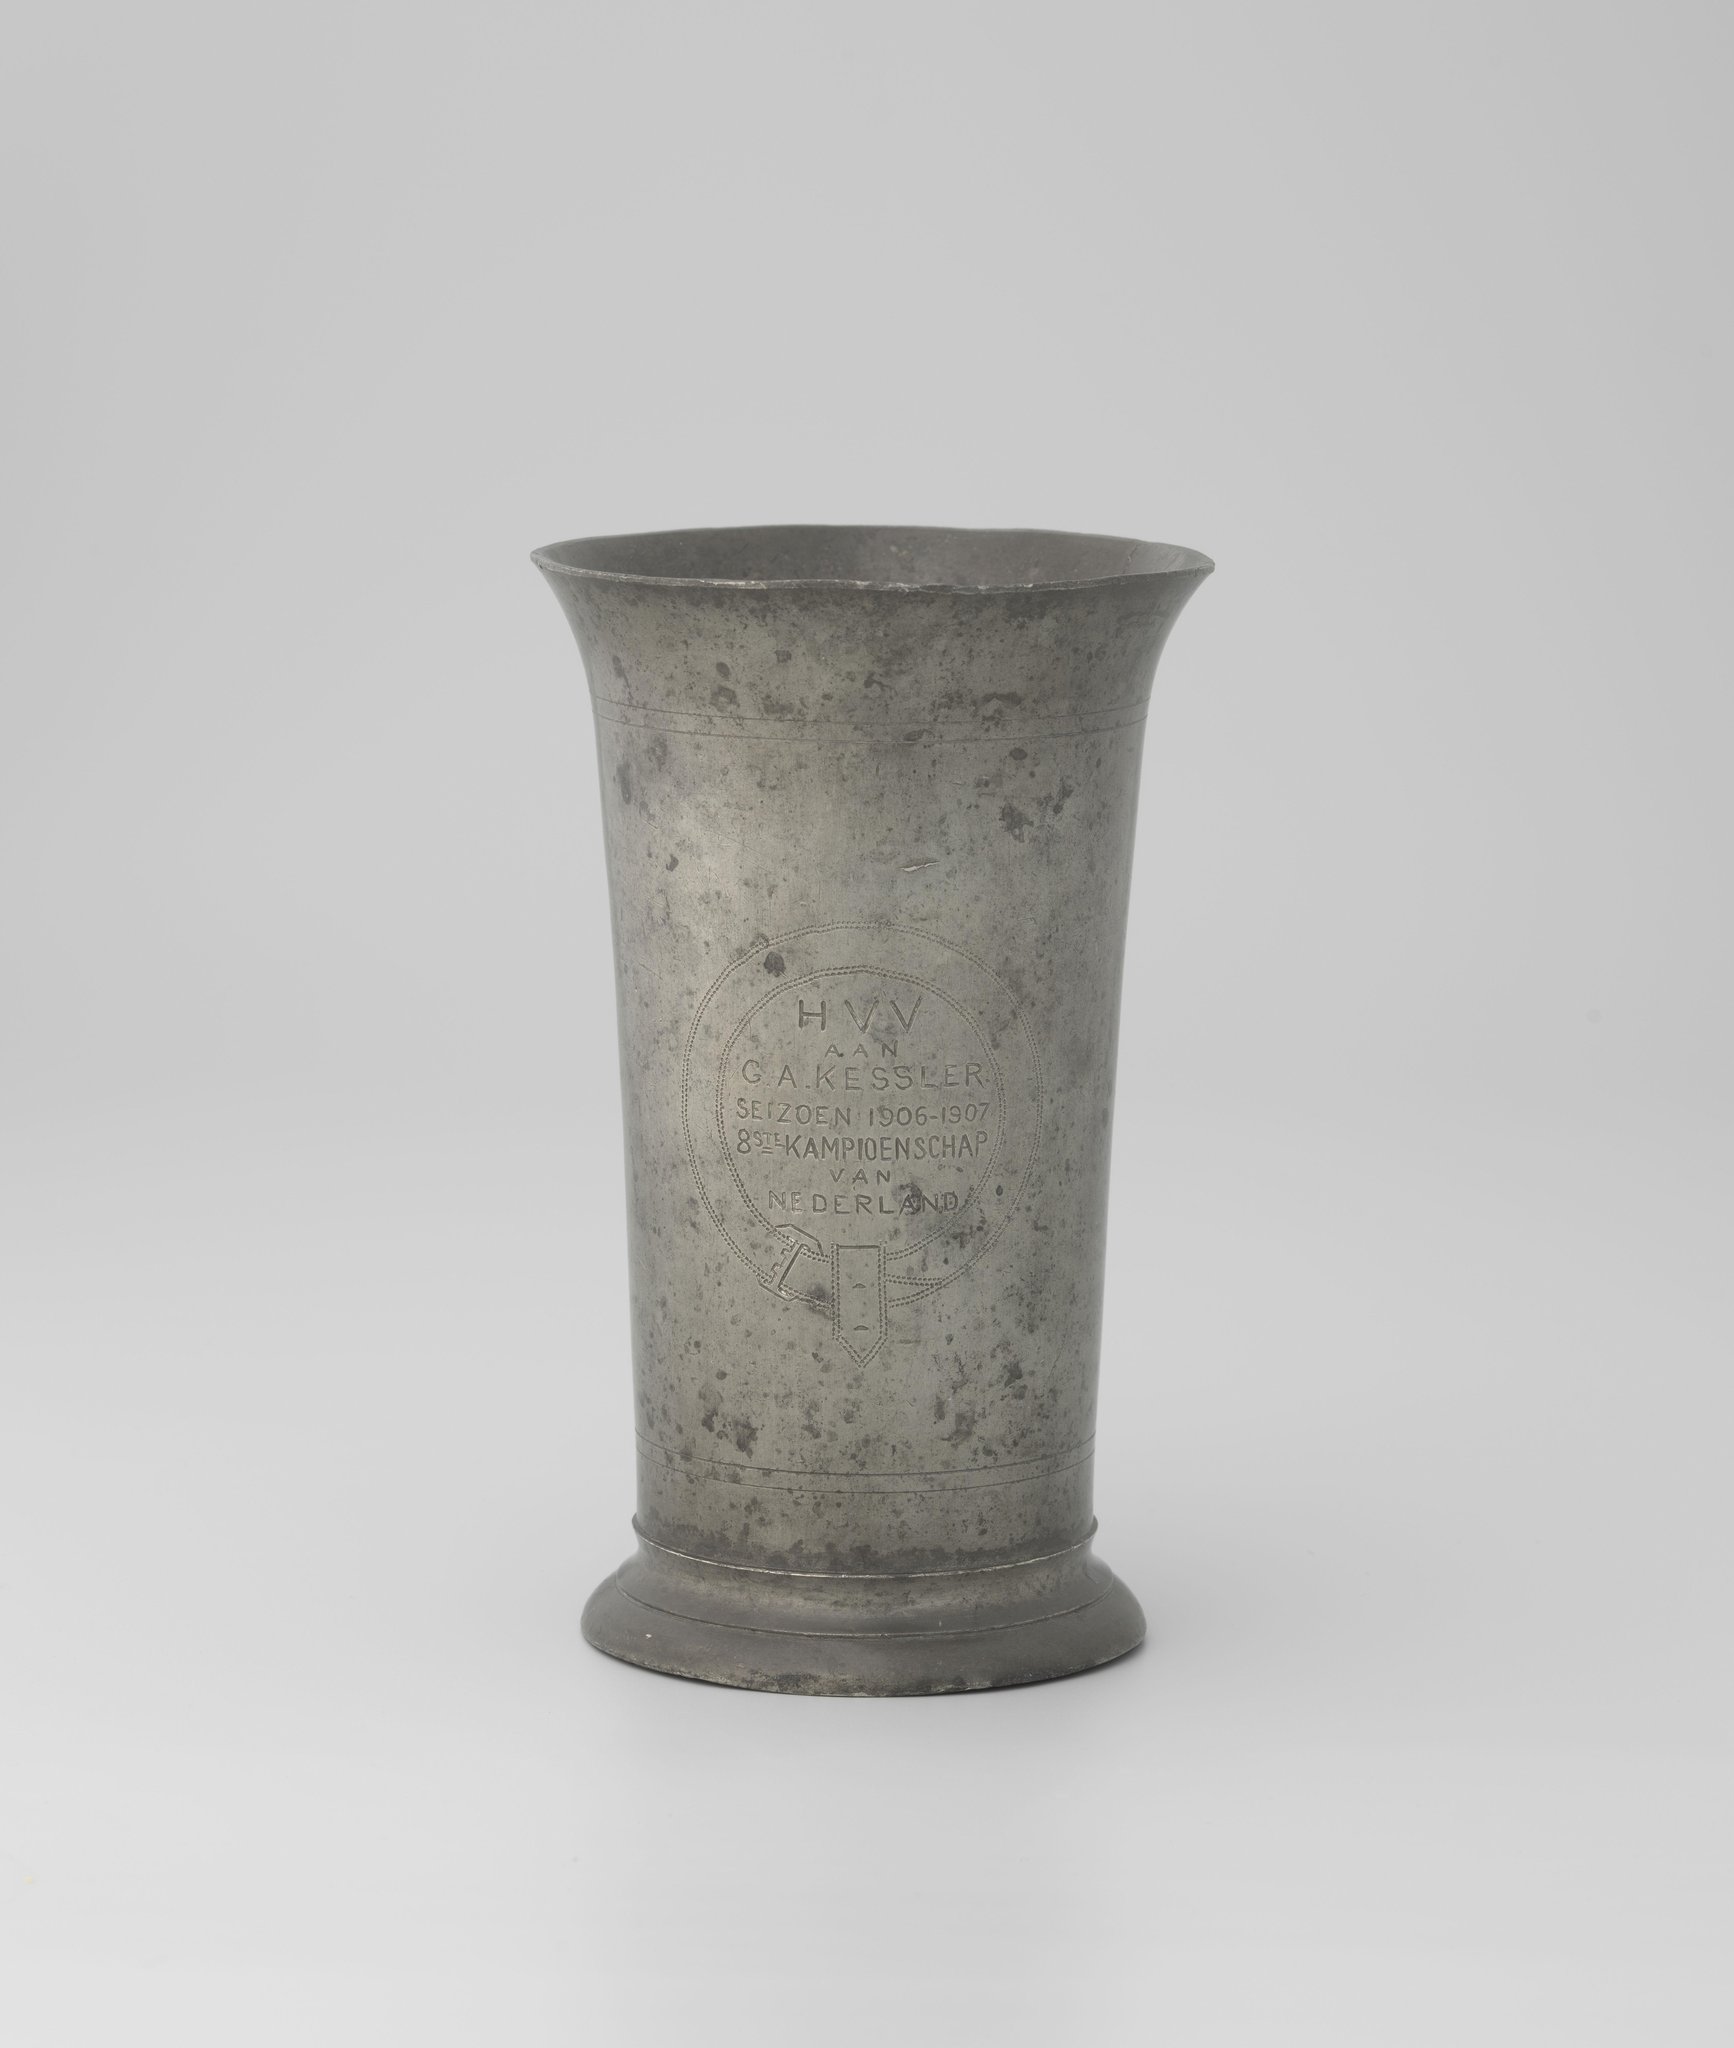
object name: cup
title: Erebeker Nederlands voetbalkampioen HVV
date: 1907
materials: tin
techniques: casting, engraving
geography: the hague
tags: haagsche voetbal vereniging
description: HVV is na Ajax (34), PSV (24) en Feyenoord (15) de voetbalclub die het vaakst kampioen van Nederland is geworden (10 x), de eerste keer in het seizoen 1890/1891, de laatste keer in 1913/1914. Deze beker is na het 8e kampioenschap (seizoen 1906/1907) door HVV uitgereikt aan de aanvoerder, Dolph (G.A.) Kessler, die gedurende dat seizoen vanwege een blessure had moeten stoppen; Kessler was in 1905 tevens de aanvoerder van het eerste Nederlands elftal. In de Rijksmuseum collectie bevinden zich vele foto's die hij als amateur nam, samen met andere familiefoto's. Hierbij horen ook enkele foto's van het eerste elftal van HVV (o.a. RP-F-2007-6-46).